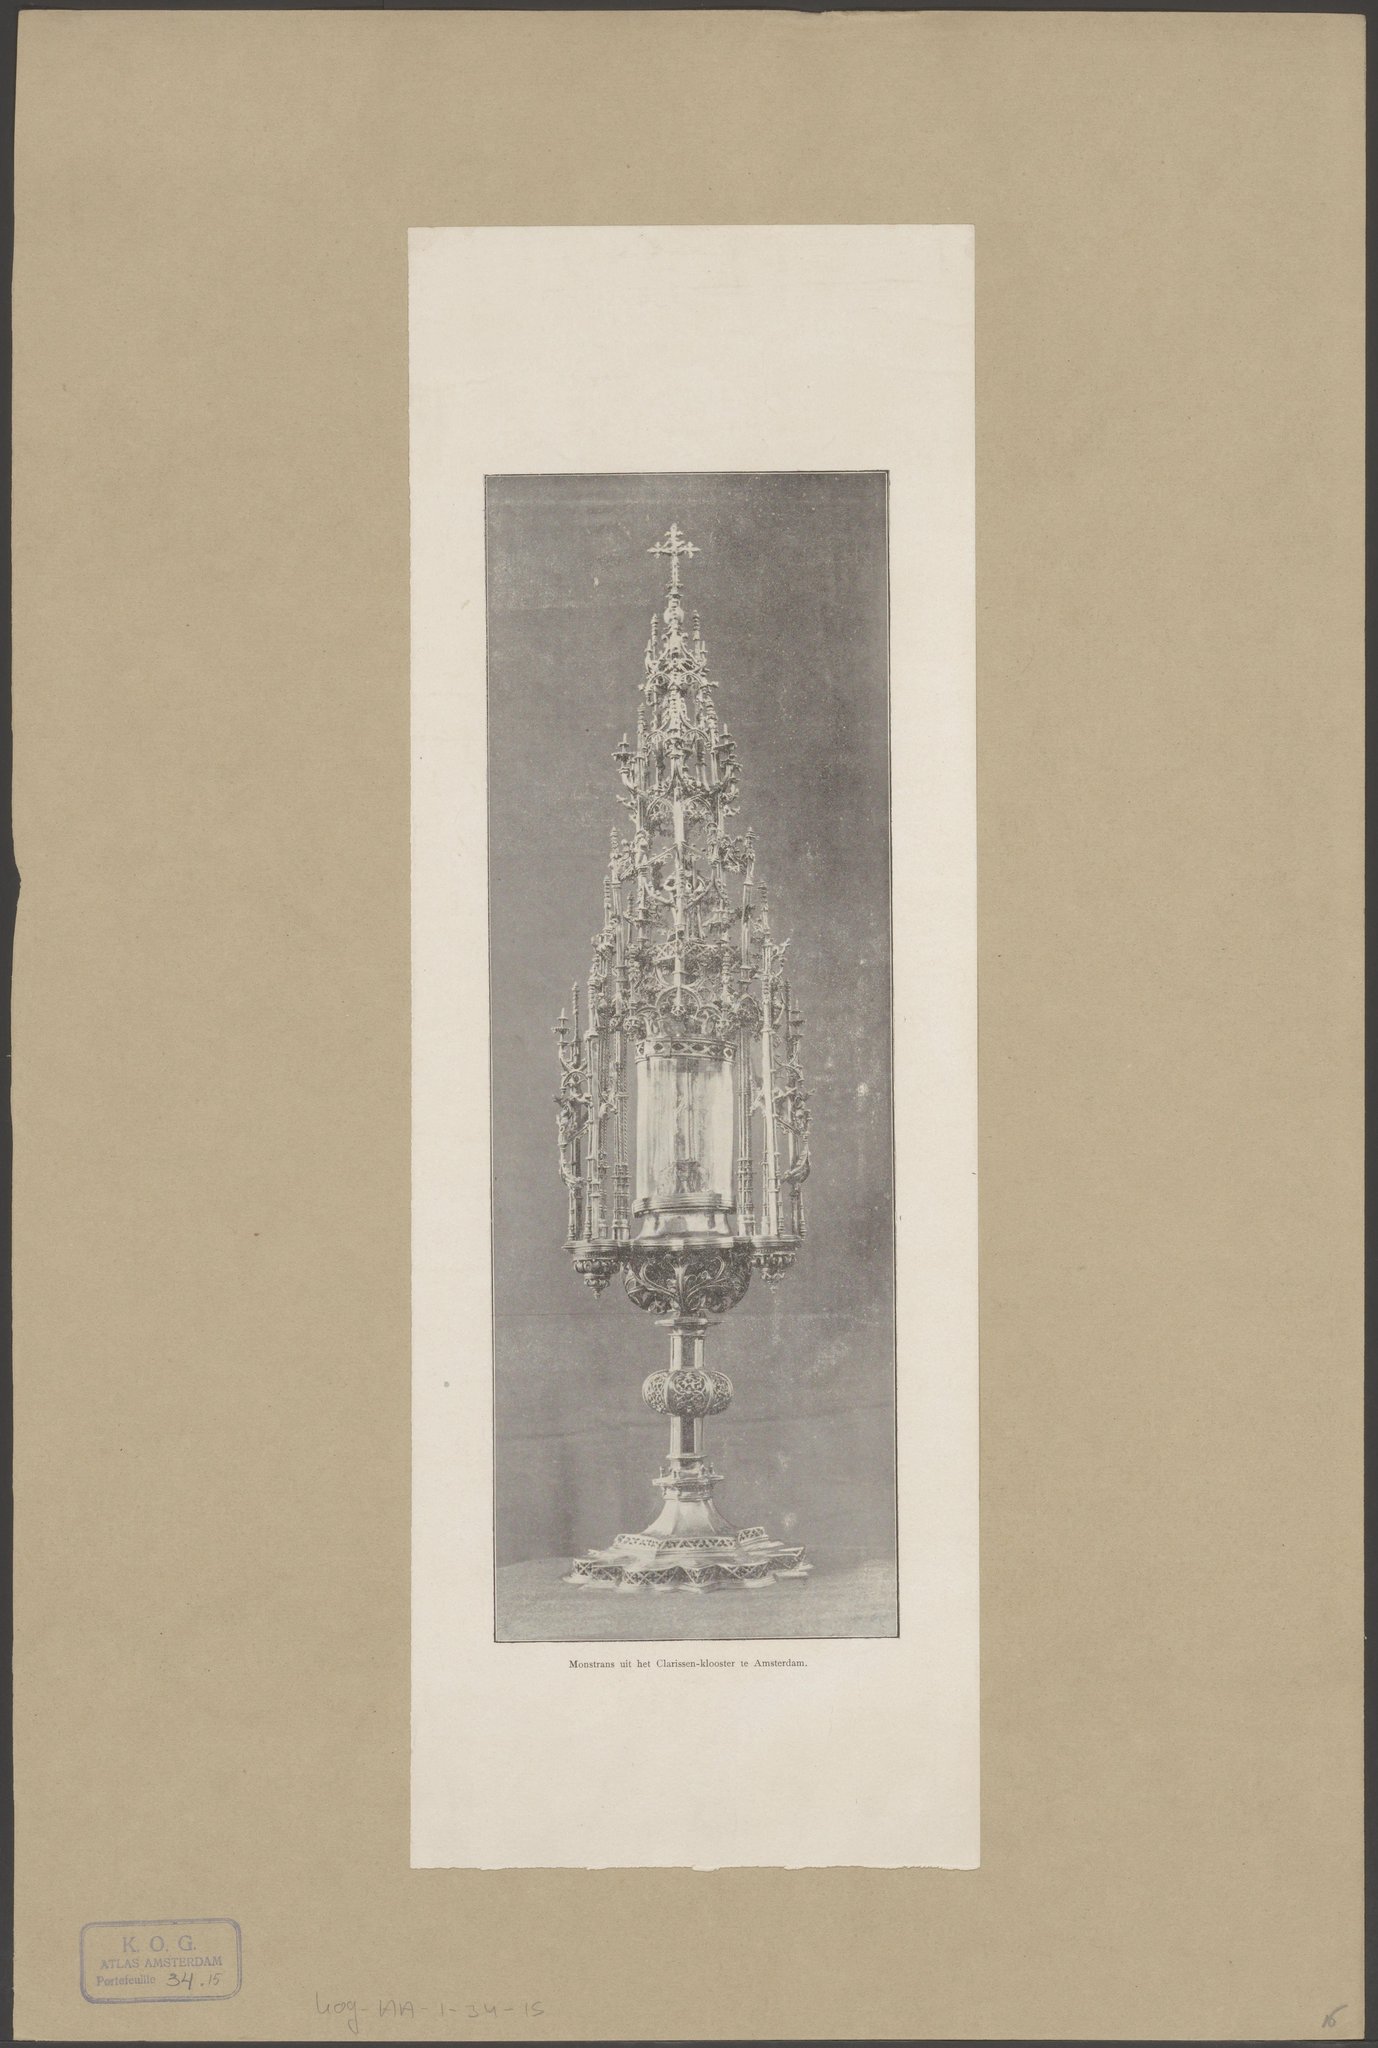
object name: photomechanical print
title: Monstrans uit het Clarissen-klooster te Amsterdam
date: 1897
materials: paper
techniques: letterpress printing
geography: haarlem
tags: ostensorium, monstrance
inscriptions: collector's mark: Lugt 1641b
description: Prent waarschijnlijk uit: Gonnet, Cornelis Jacobus, e.a., red. Bijdragen voor de geschiedenis van het bisdom van Haarlem. Haarlem: W. Küppers, 1897, dl. 22.